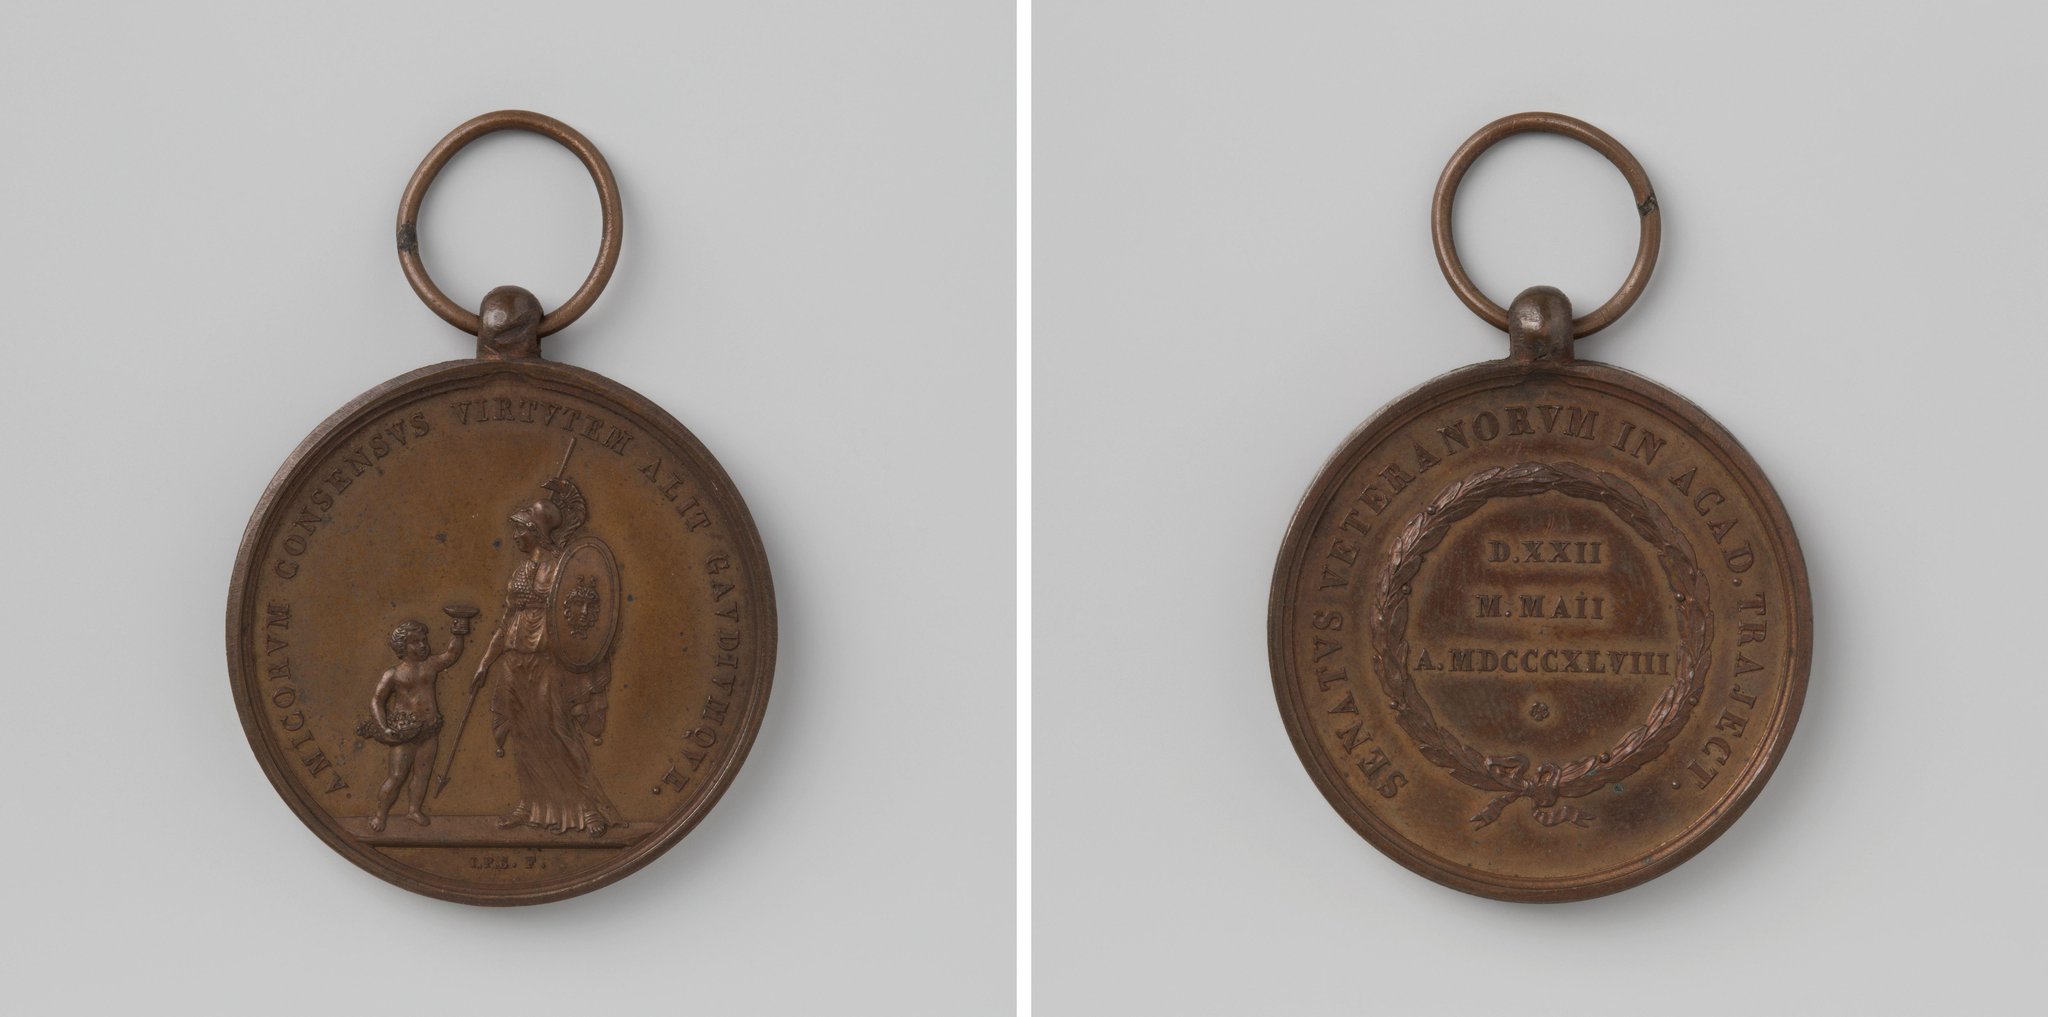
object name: history medal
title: Senatus Veteranorum van de hogeschool te Utrecht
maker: johannis petrus schouberg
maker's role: die cutter, draughtsman, print maker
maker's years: 1798-1864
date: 1848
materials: bronze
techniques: striking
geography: utrecht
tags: utrecht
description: Bronzen penning met draagoog en draagring. Voorzijde: gehelmde Minerva met schild enspeer krijgt van jongentje beker aangereikt binnen omschrift; afsnede: signatuur. Keerzijde:datum binnen lauwerkrans en omschrift